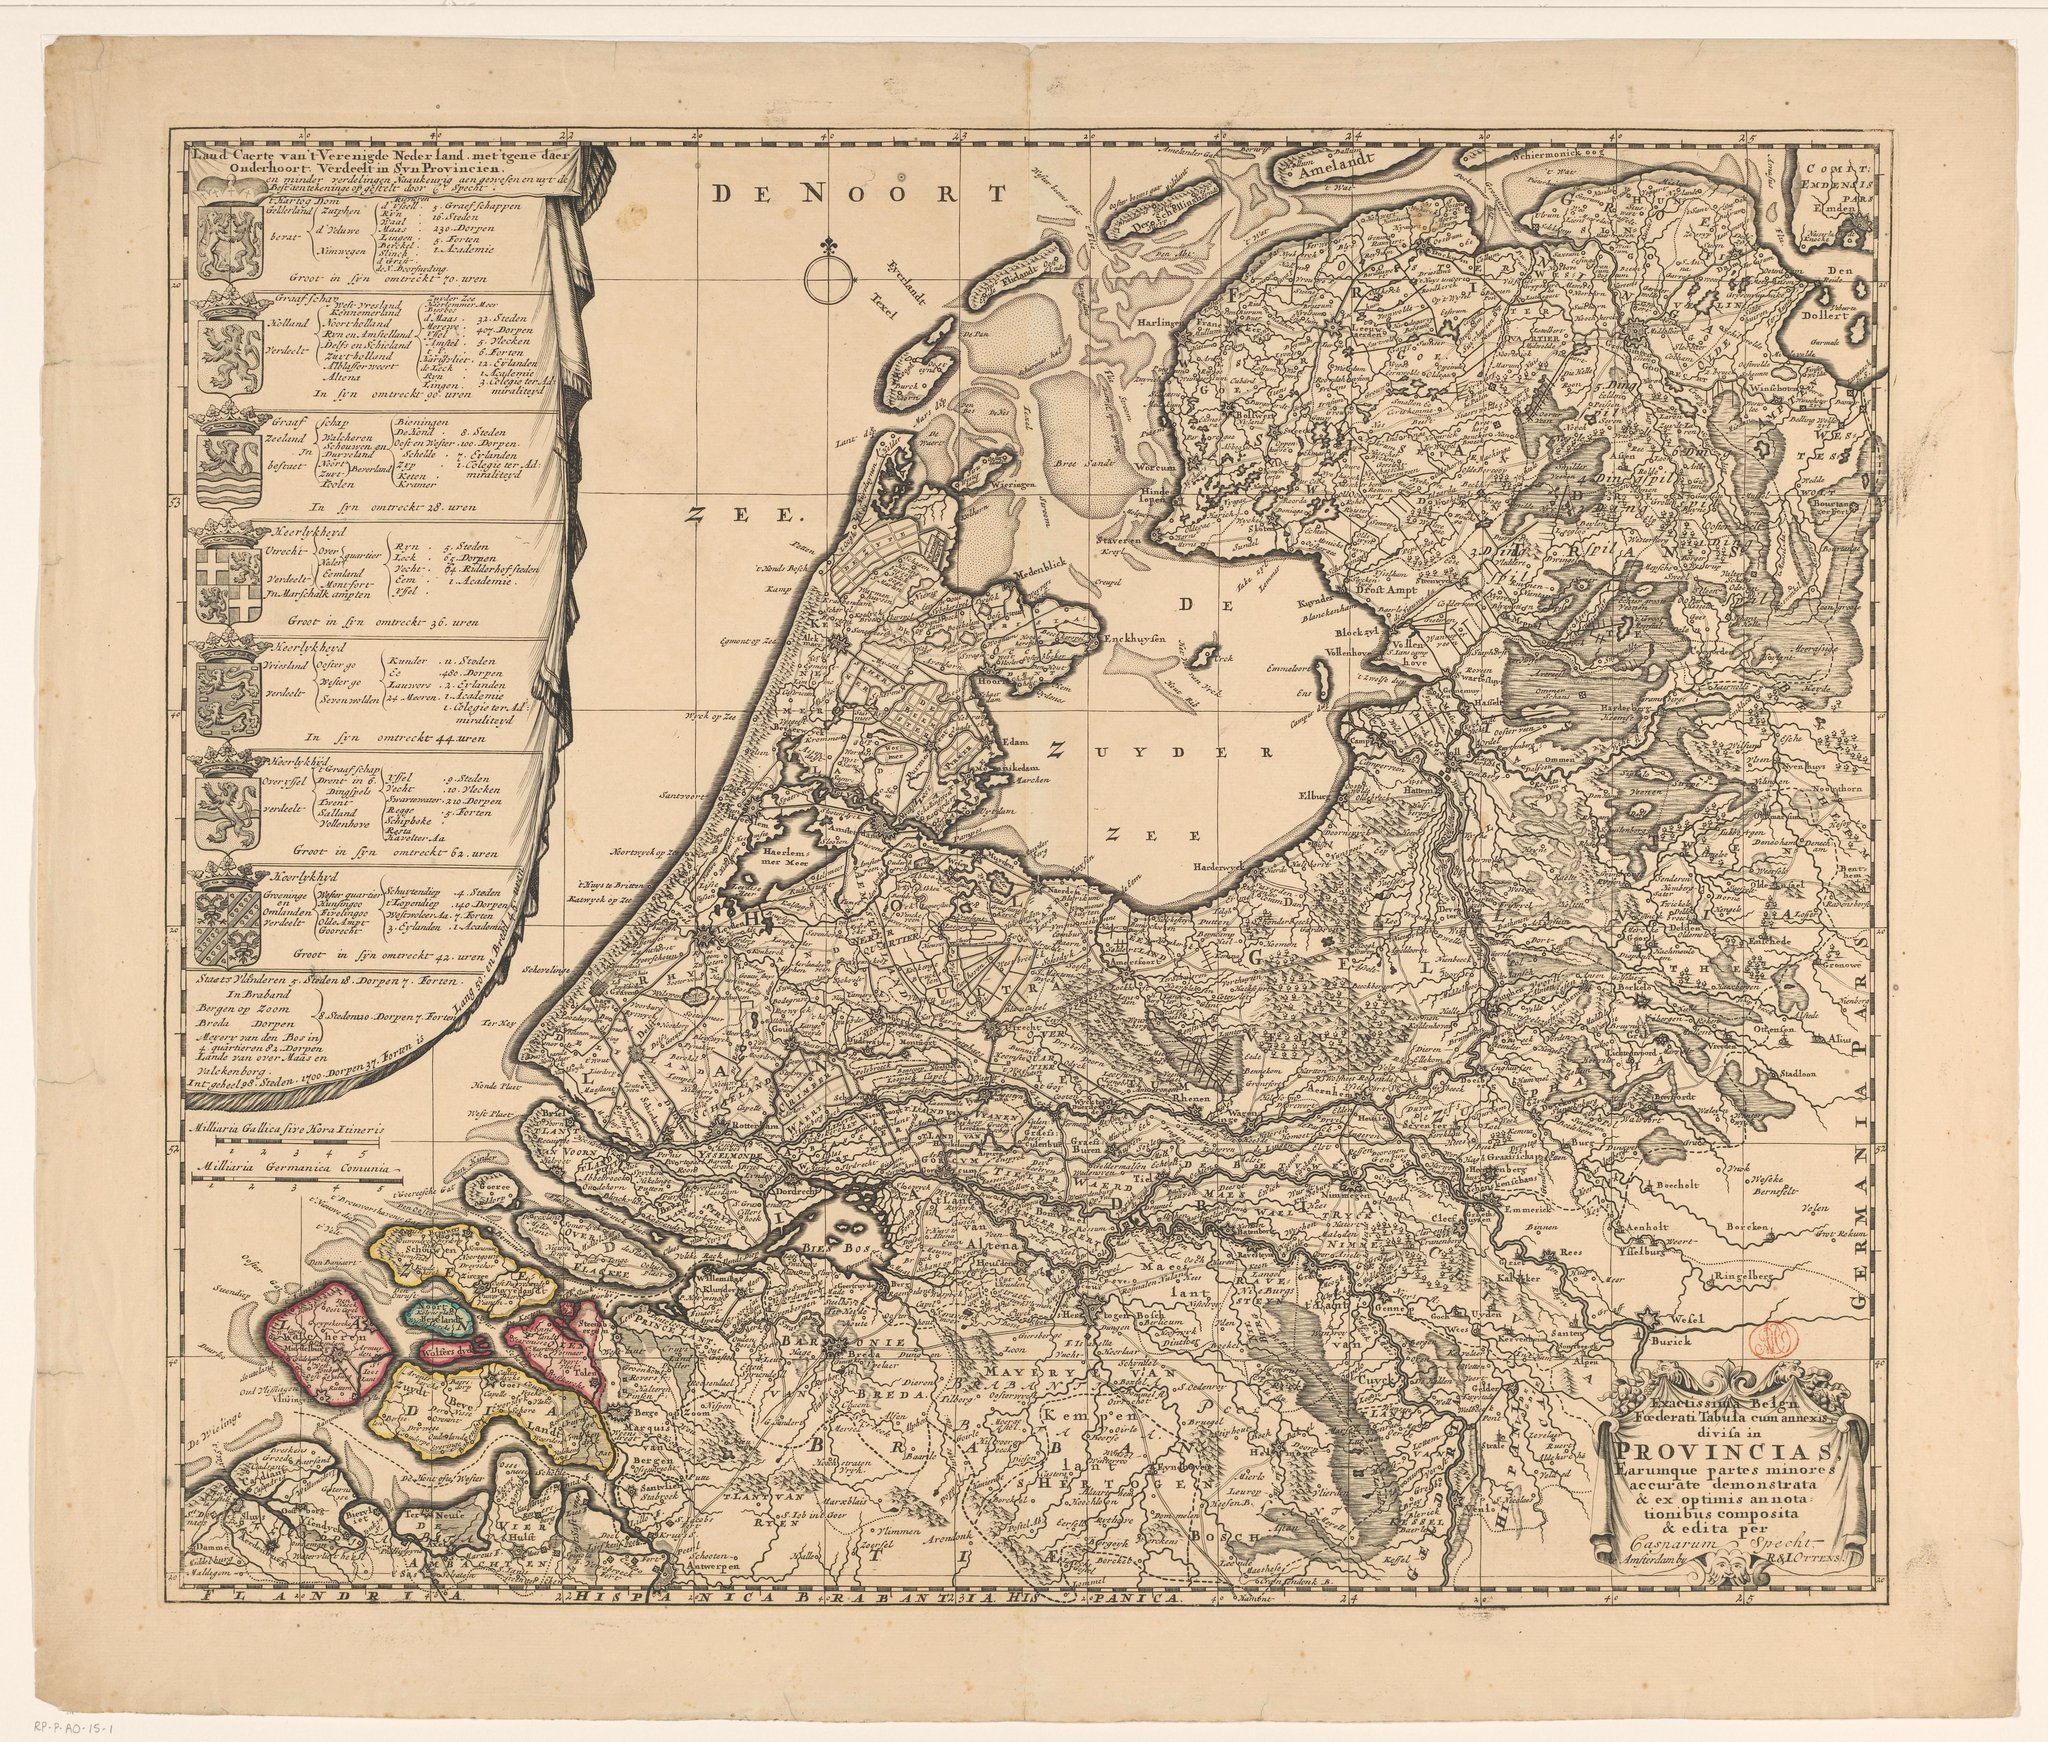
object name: print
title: Kaart van de Republiek der Zeven Verenigde Nederlanden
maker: caspar specht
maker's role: print maker, publisher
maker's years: 1654-1710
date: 1702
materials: paper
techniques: engraving, hand coloring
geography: amsterdam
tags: maps of separate countries or regions, coat of arms (as symbol of the state, etc.) (+ province; provincial), netherlands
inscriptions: collector's mark: Lugt 195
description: Links een langwerpige cartouche met daarin de Nederlandse titel en de wapens van en topografische en staatkundige informatie over de Zeven Provinciën. Daaronder twee schaalstokken: Milliaria Gallica sive hora itineris; Milliaria Germanica comunia. Rechtsonder een cartouche met de Latijnse titel. De kaart is voorzien van een coördinaten-net en een gradenverdeling langs randen. Zeeland is gekleurd.